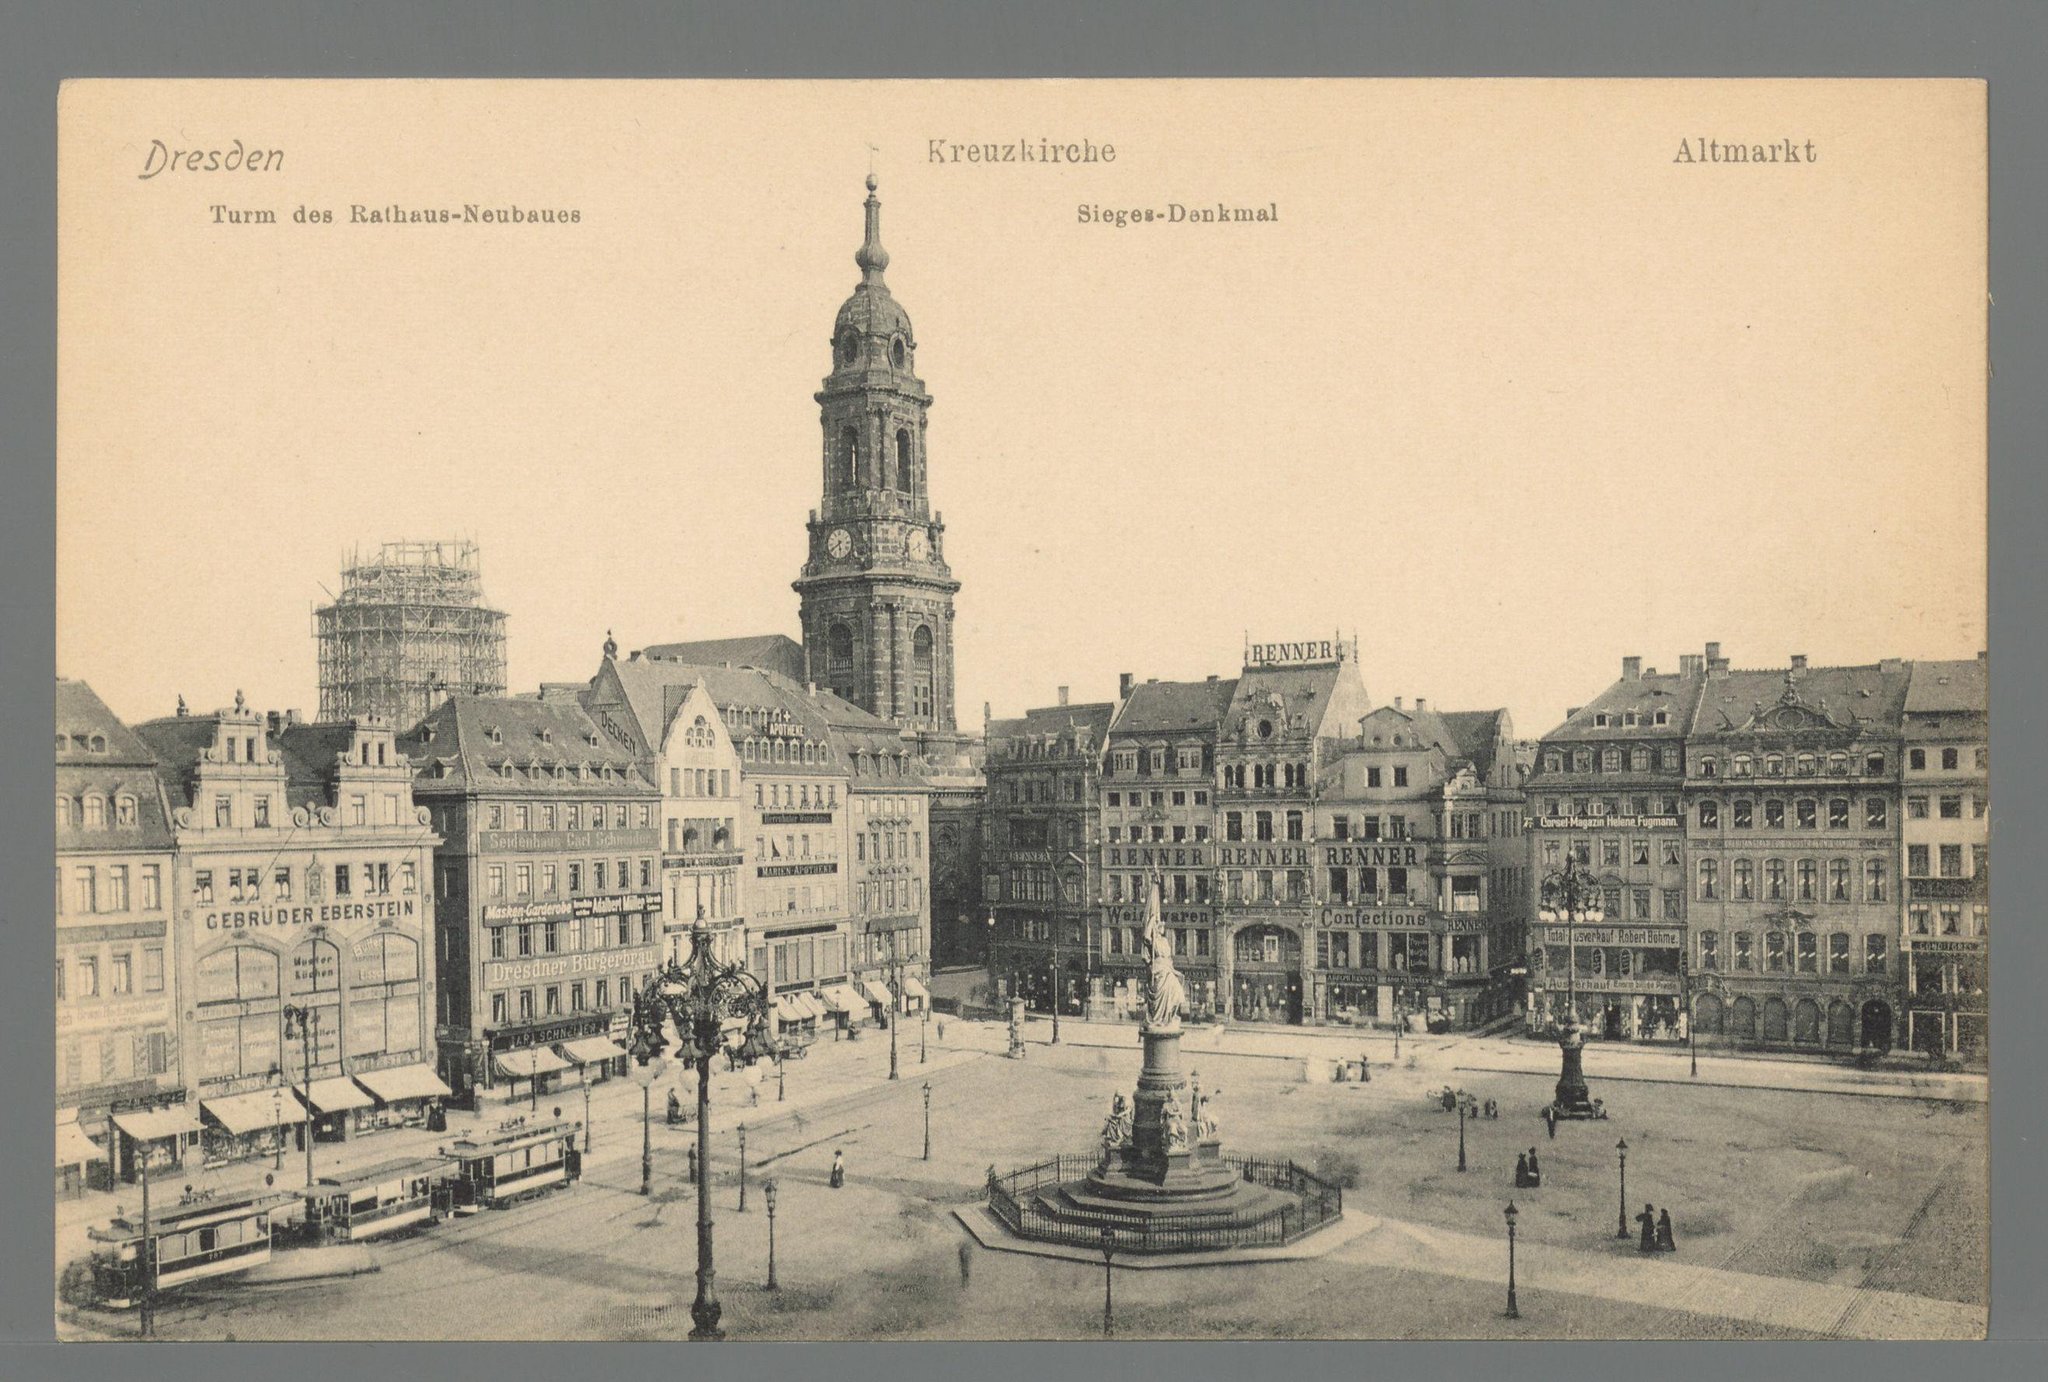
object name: photomechanical print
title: Dresden. Kreuzkirche. Altmarkt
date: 1905-1930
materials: cardboard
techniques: photograph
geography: dresden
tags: square, place, circus, etc., church (exterior), monument, statue